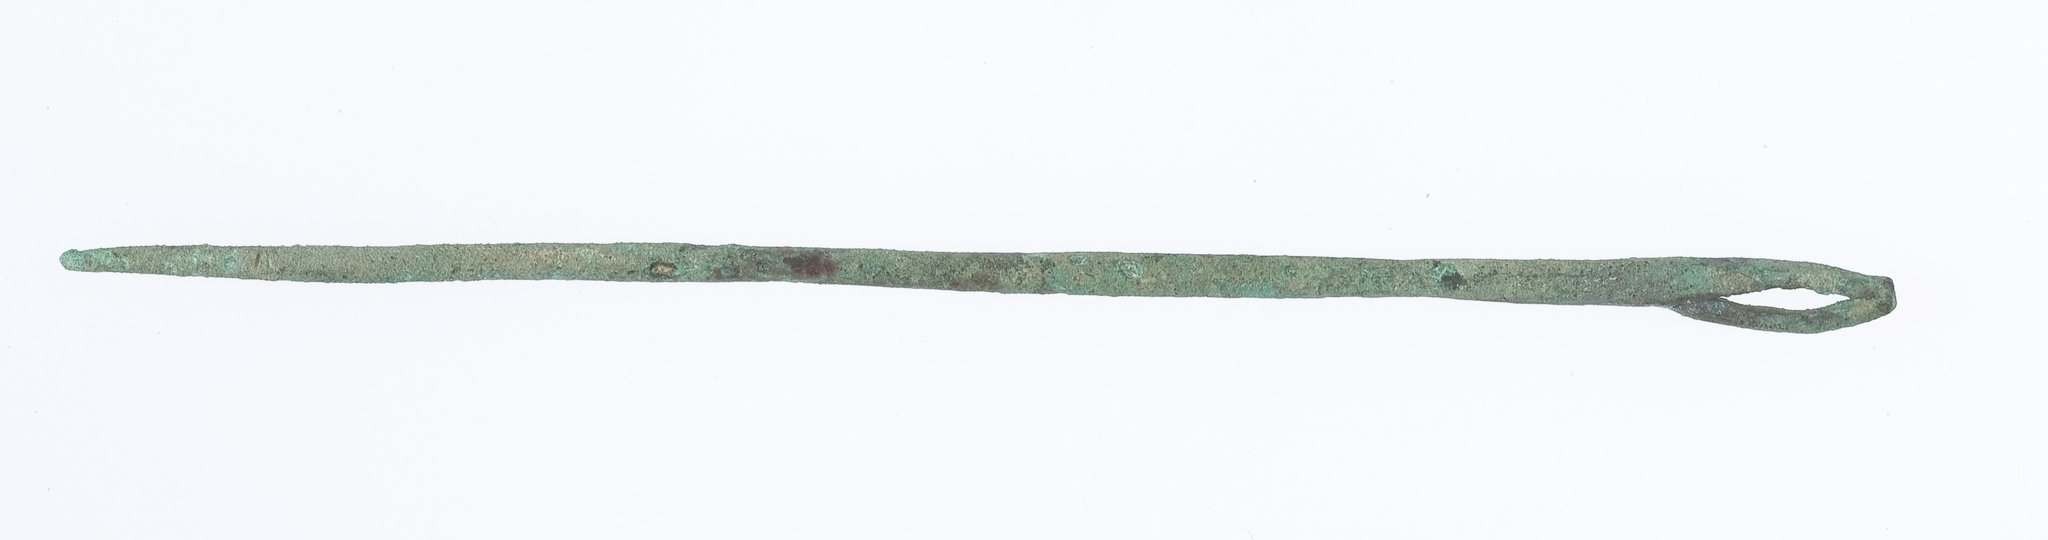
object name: needle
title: Textile manufacturing tool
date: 1295-1070 BCE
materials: bronze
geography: egypt